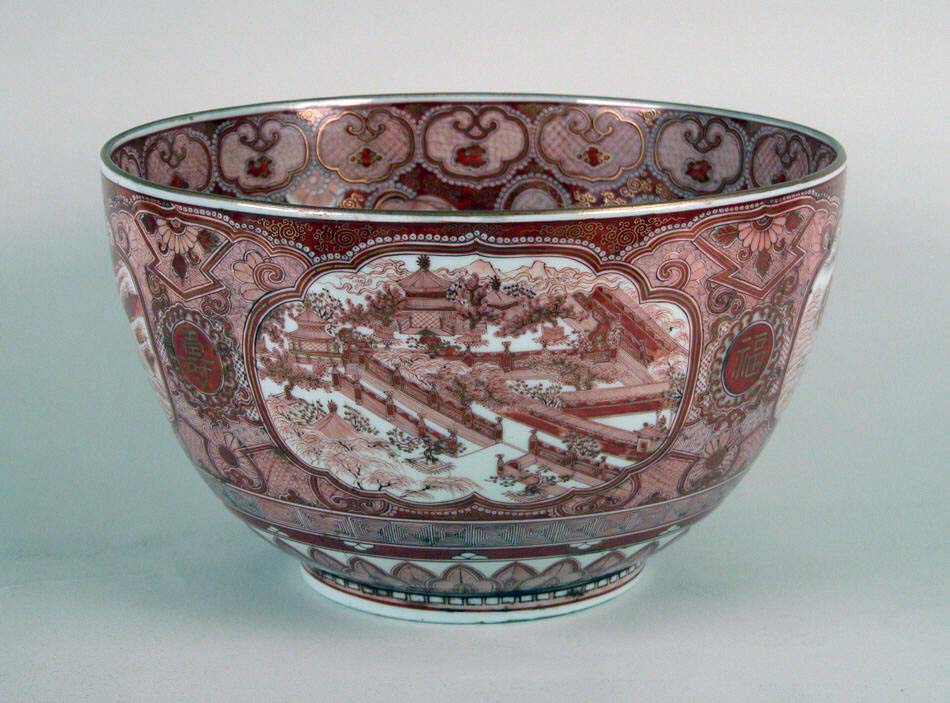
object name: bowl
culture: japanese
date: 1701-1800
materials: gold, iron, porcelain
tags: dragons